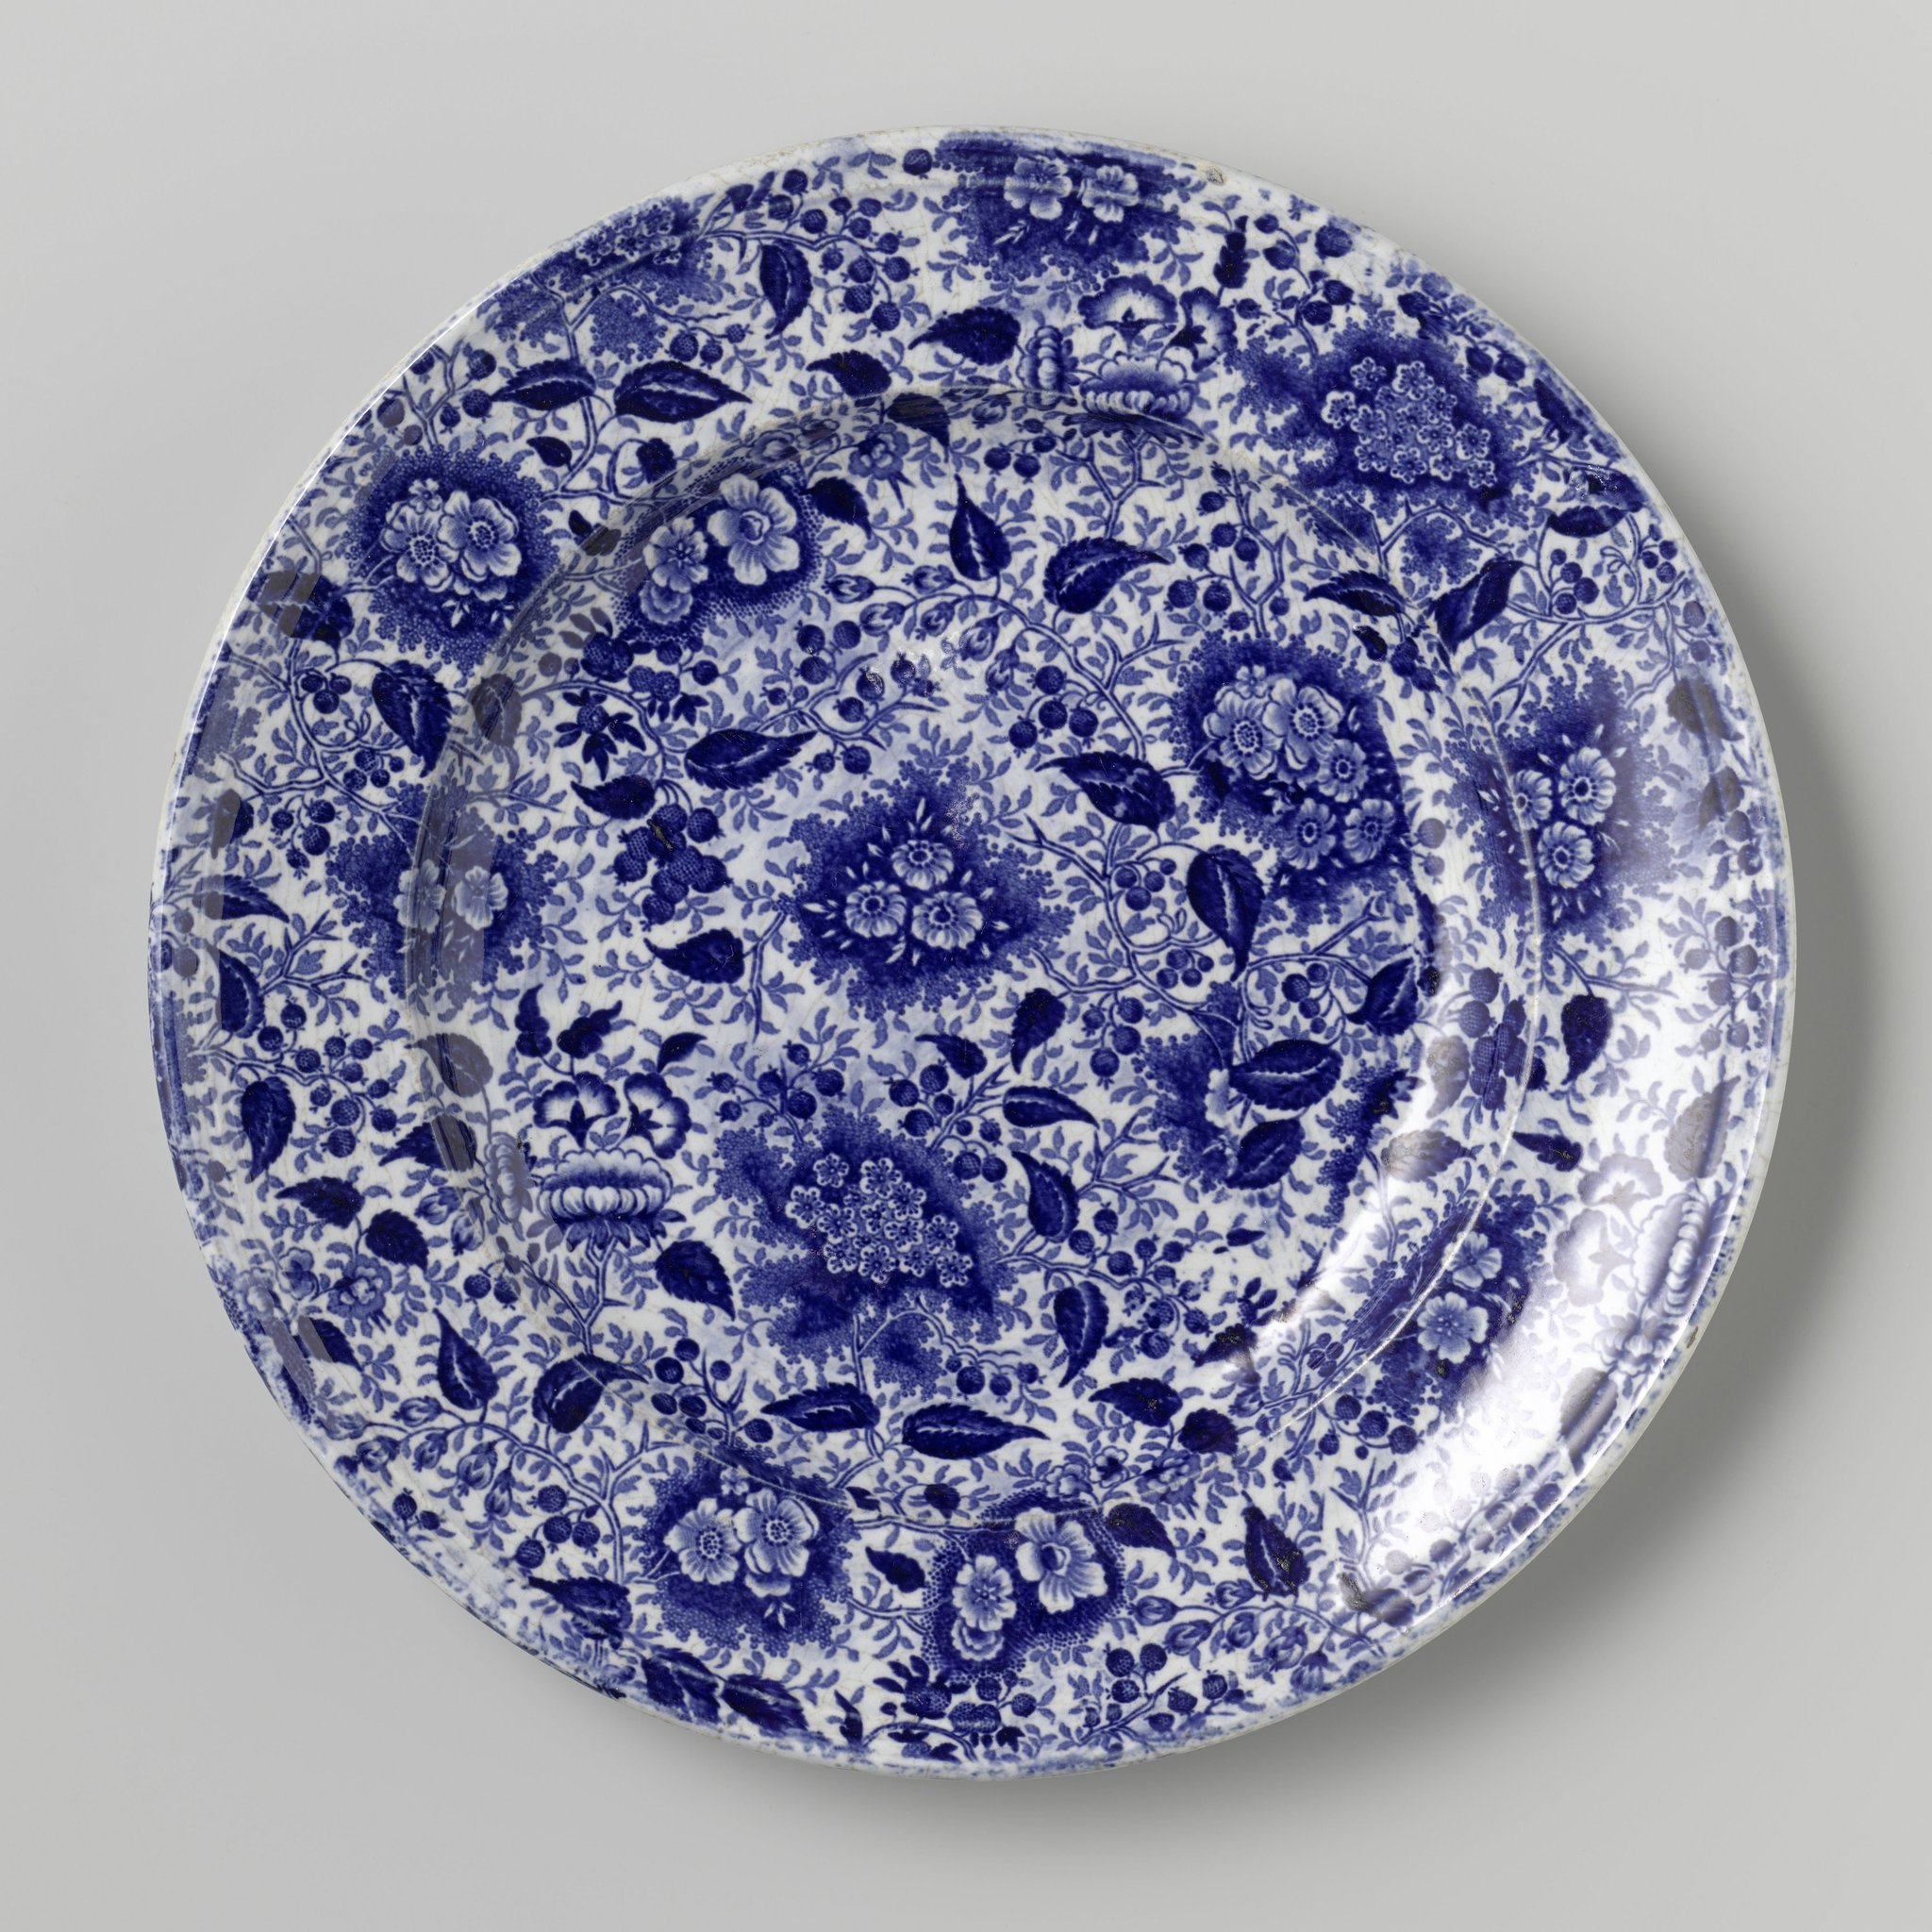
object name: plate dish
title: Bord van aardewerk met parsemé-decor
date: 1850-1859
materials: earthenware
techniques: transfer printed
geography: maastricht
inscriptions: check stamp: ‘CC’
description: Bord van aardewerk, versierd met een parsemé-decor in onderglazuurblauwe transferdruk.